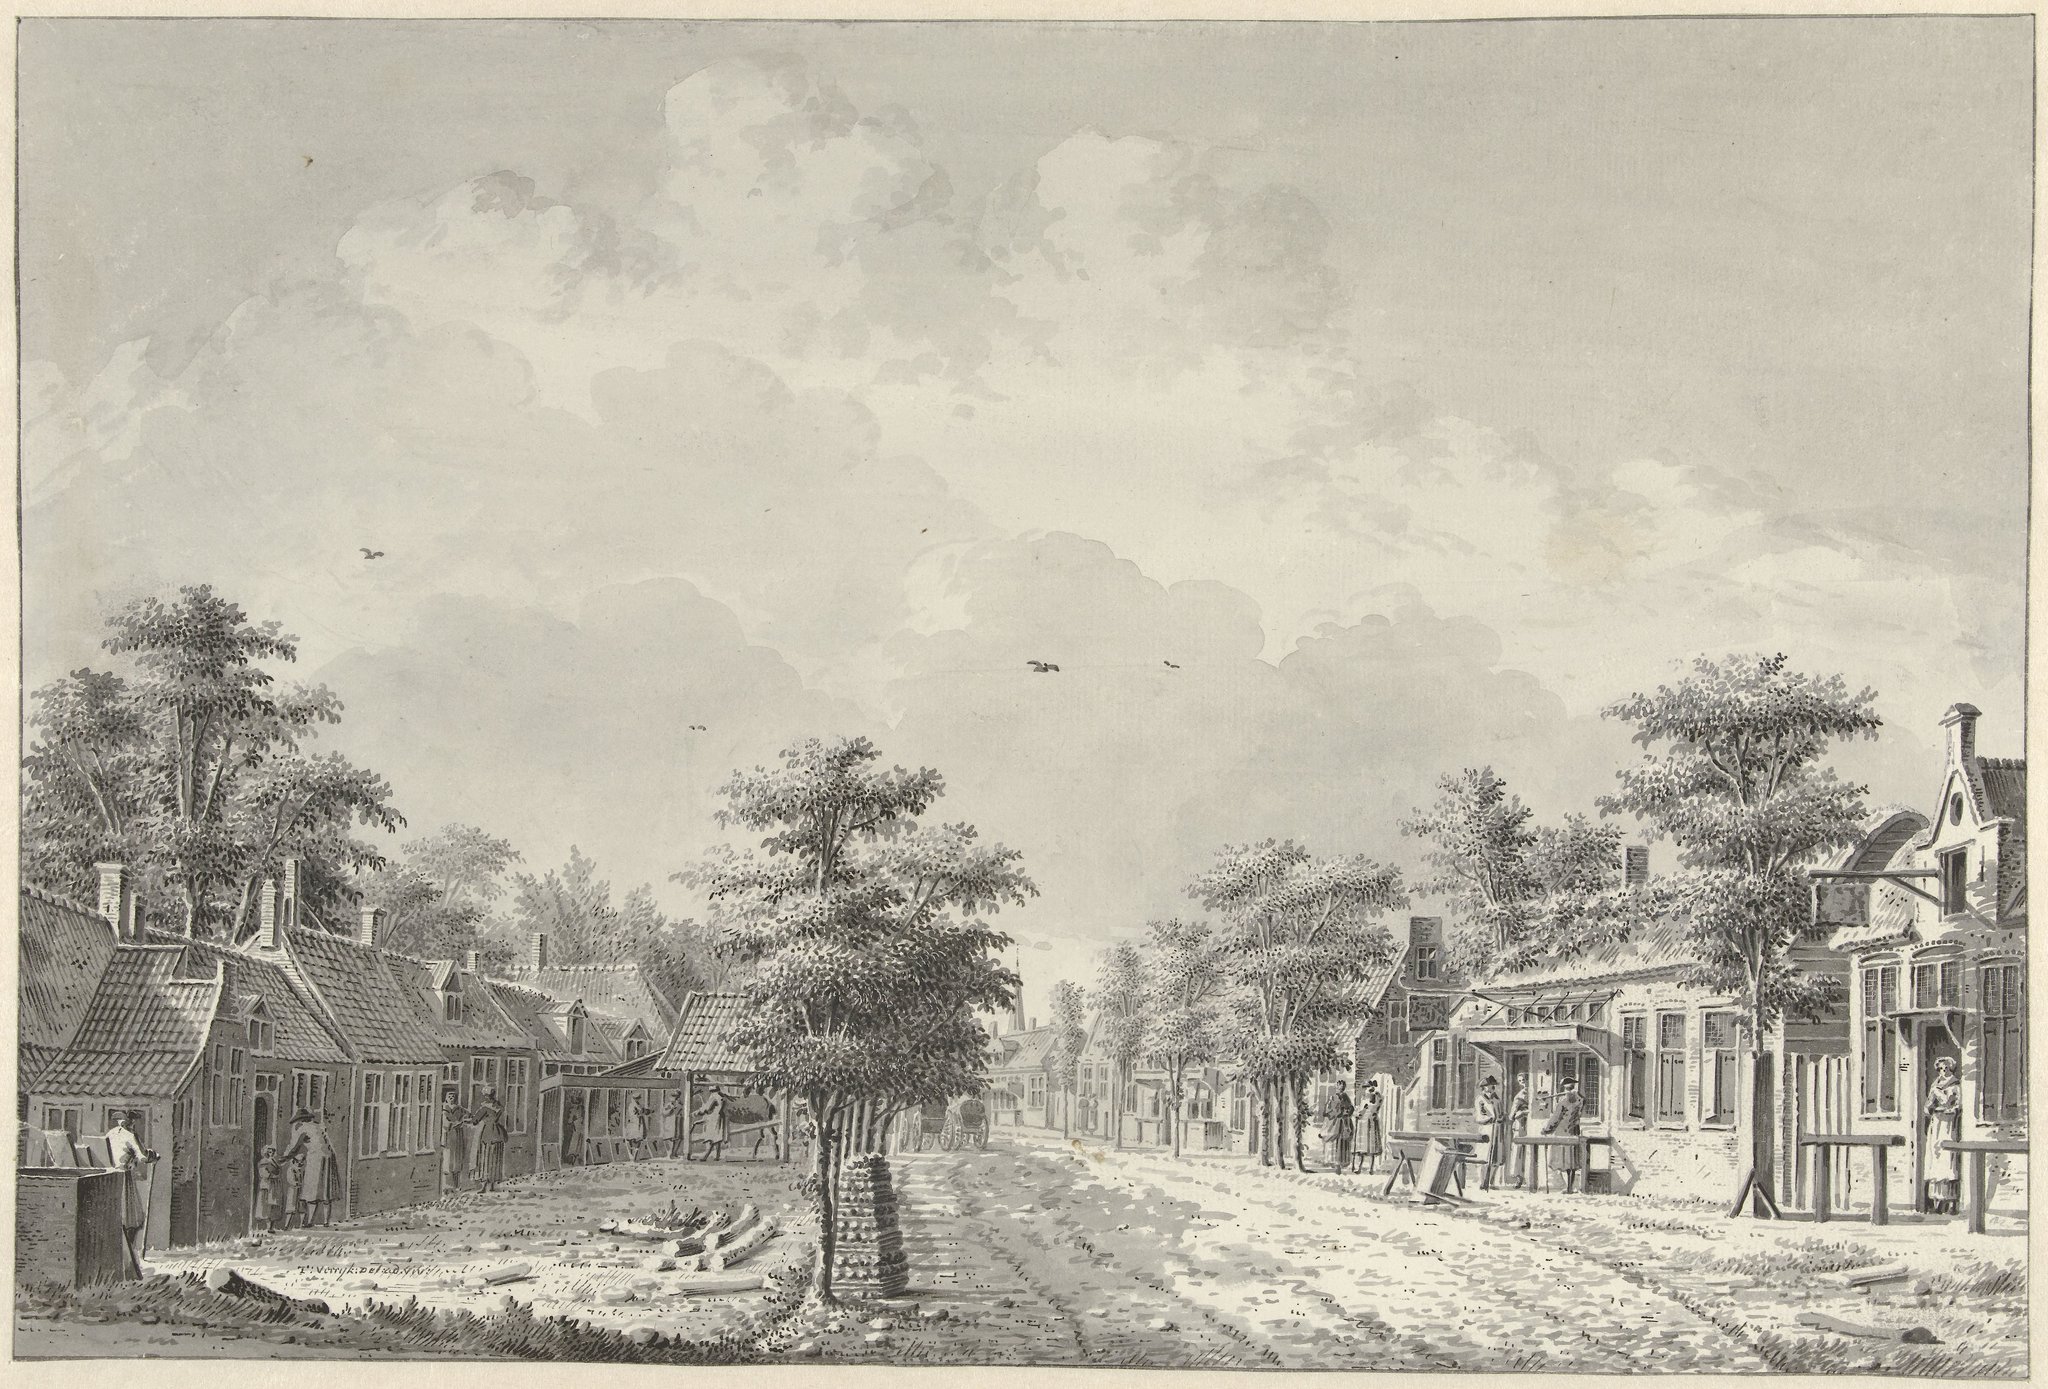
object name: drawing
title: Gezicht op het dorp De Bilt vanaf de Hollebeld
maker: dirk verrijk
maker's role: draughtsman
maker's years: 1734-1786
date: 1744-1786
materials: ink, paper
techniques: brush, pen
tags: public road in village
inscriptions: signature: ‘T. Verryk del. ad. viv’, inscription: ‘Gezigt het dorp de Bild van de Hollebeld te zien / 1/2 uur geleege van de stad Utrecht’